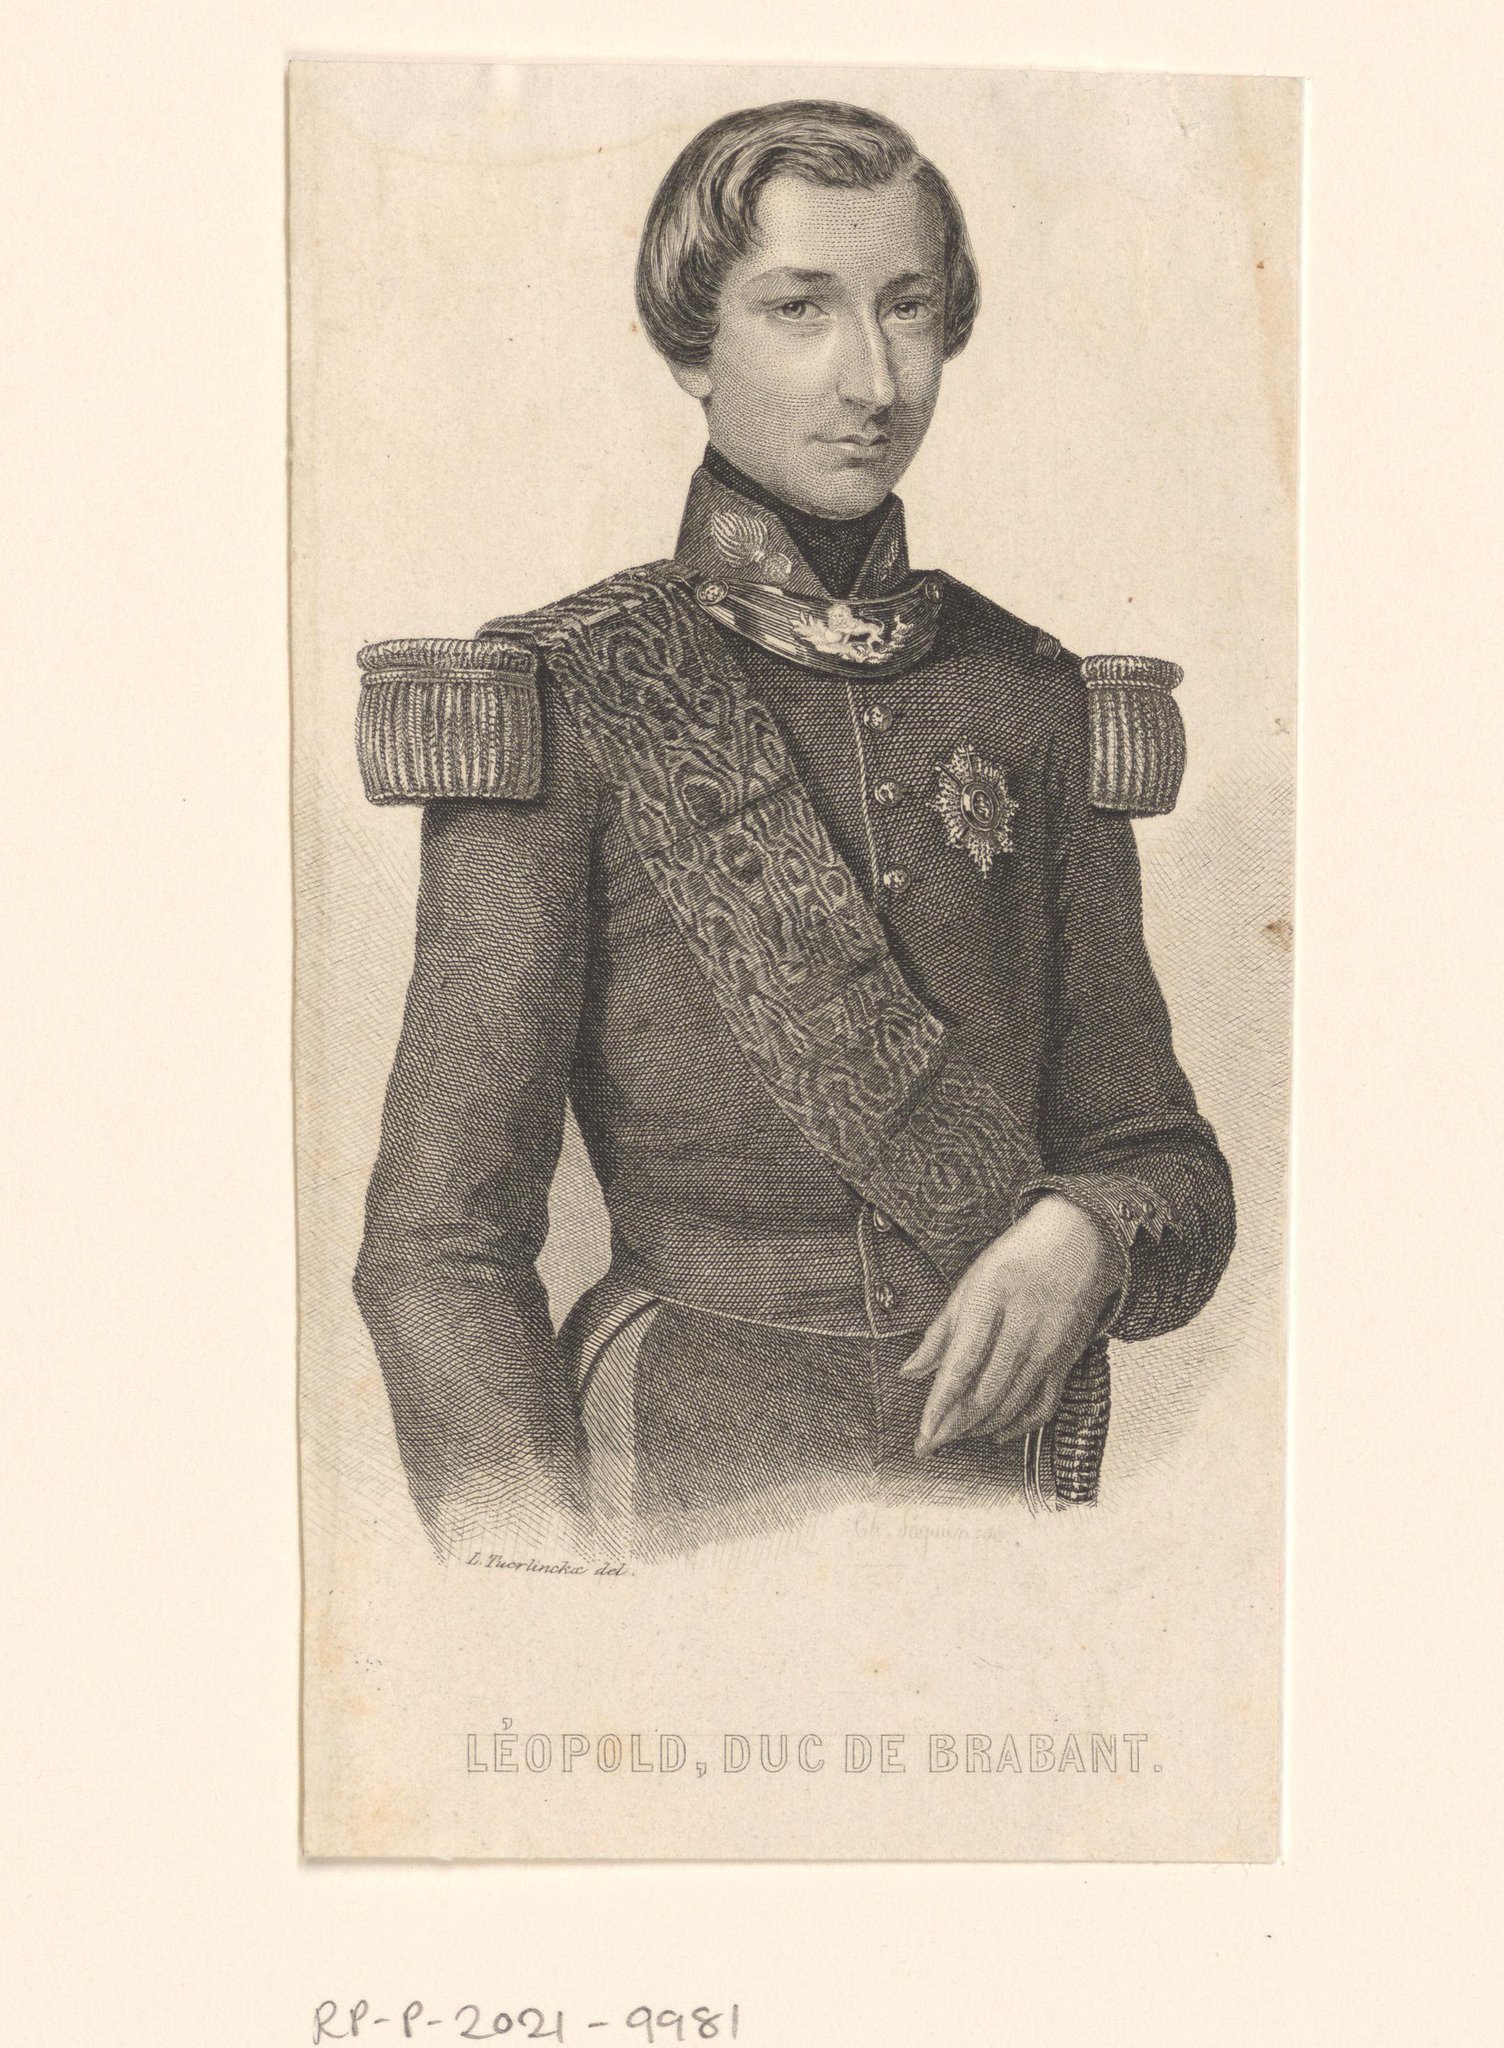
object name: print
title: Portret van Leopold II, koning der Belgen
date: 1845-1865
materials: paper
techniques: engraving, etching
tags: brussels, leopold ii (koning der belgen), historical persons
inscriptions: signature: ‘Ch. Saquien’